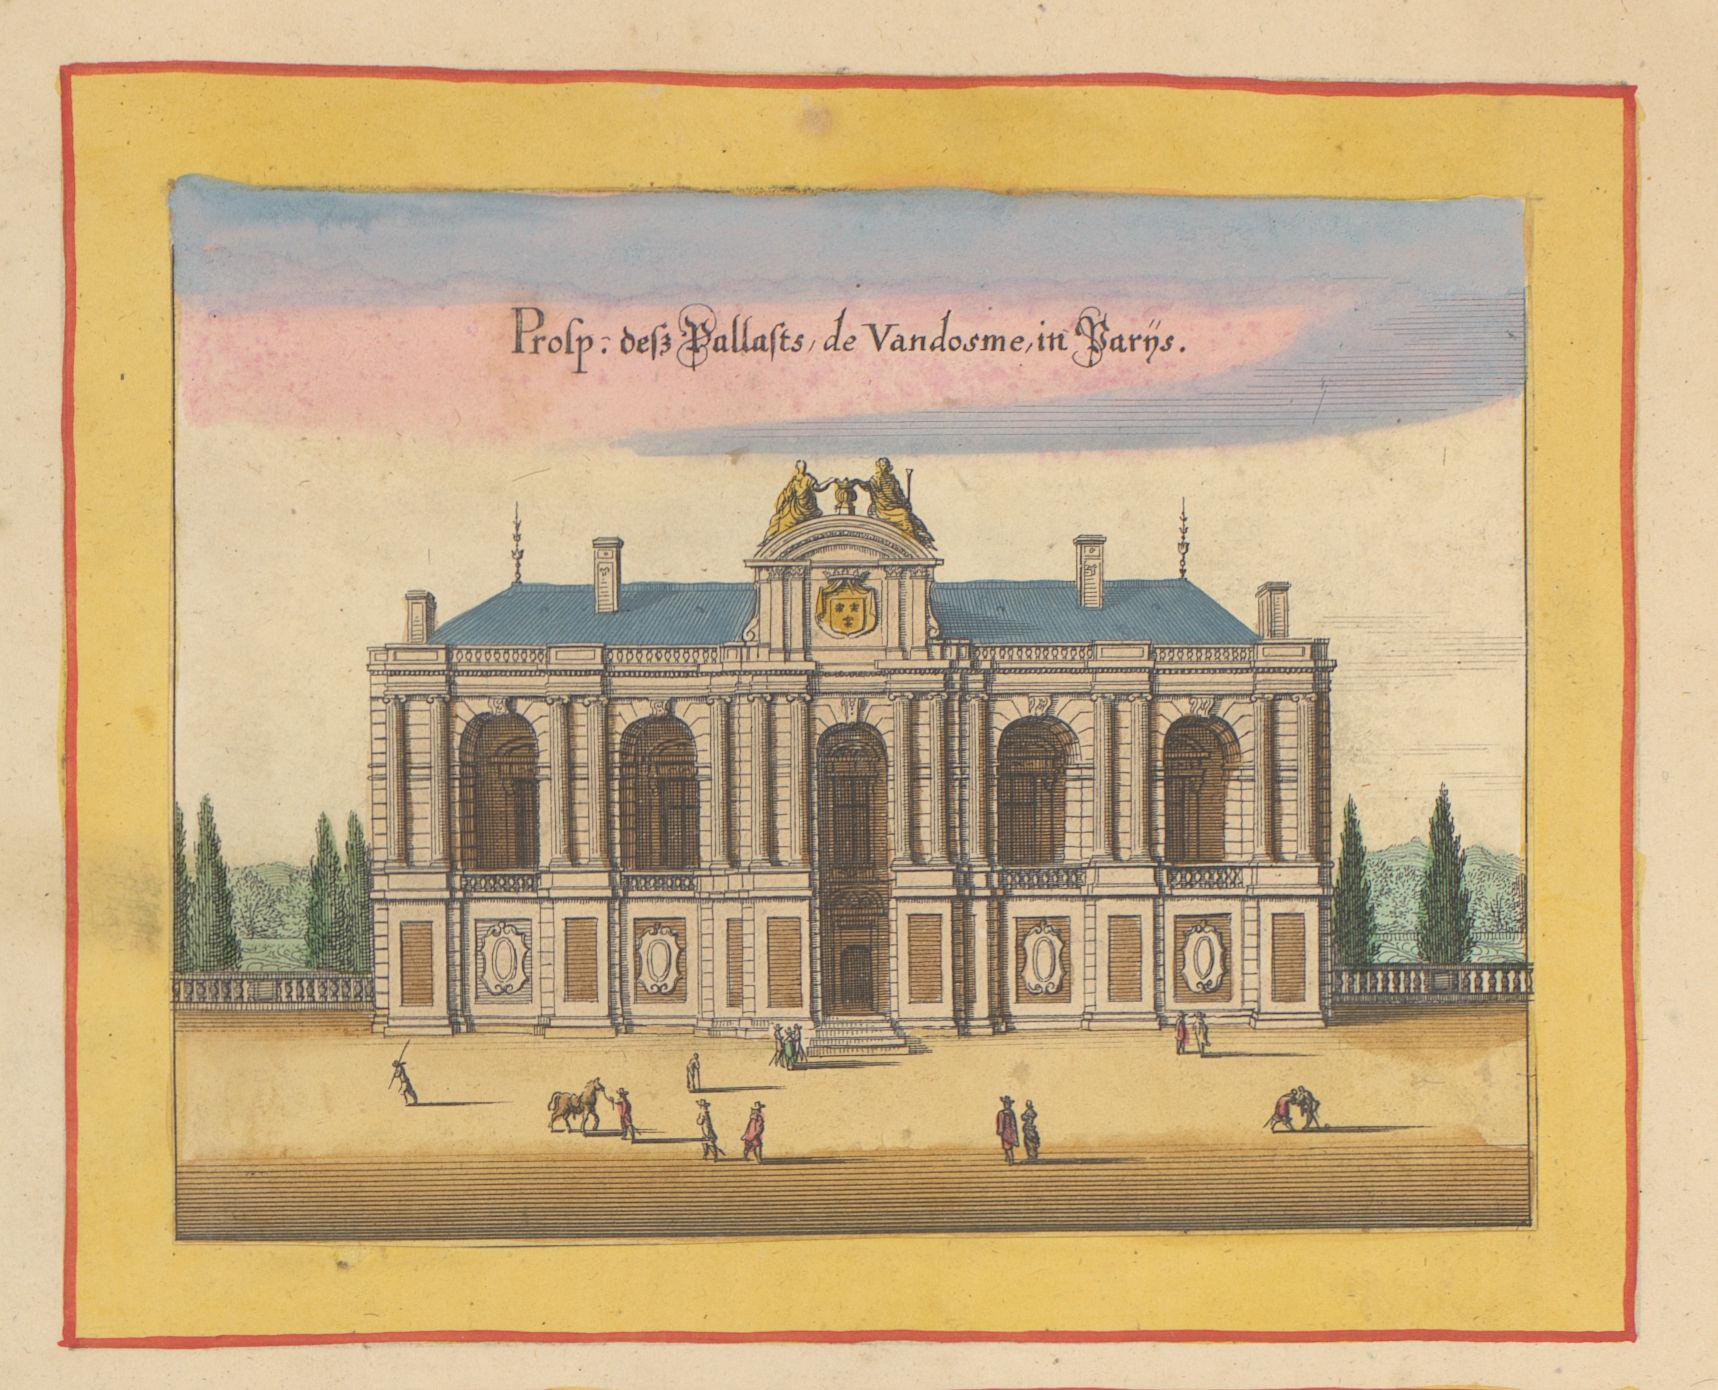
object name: album leaf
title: Gezicht op Hôtel de Vendôme te Parijs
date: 1655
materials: paper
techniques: engraving, etching, hand coloring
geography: frankfurt am main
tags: hôtel, i.e. small palace in city, paris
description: Prent origineel vervaardigd als boekillustratie voor: Zeiller, Martin. Topographia Galliae, oder Beschreibung und Contrafaitung der vornehmbsten und bekantisten Oerter in dem mächtigen und grossen Königreich Frankreich, 13 delen. Frankfurt am Main: Caspar Merian, 1655-1661. De prent werd voor het eerst gepubliceerd in deel 1: Topographia Galliae, 1655. De prent is langs de bovenrand van de voorstelling afgescheurd. De voorstelling is aan de bovenzijde aangevuld met een geschilderde lucht.